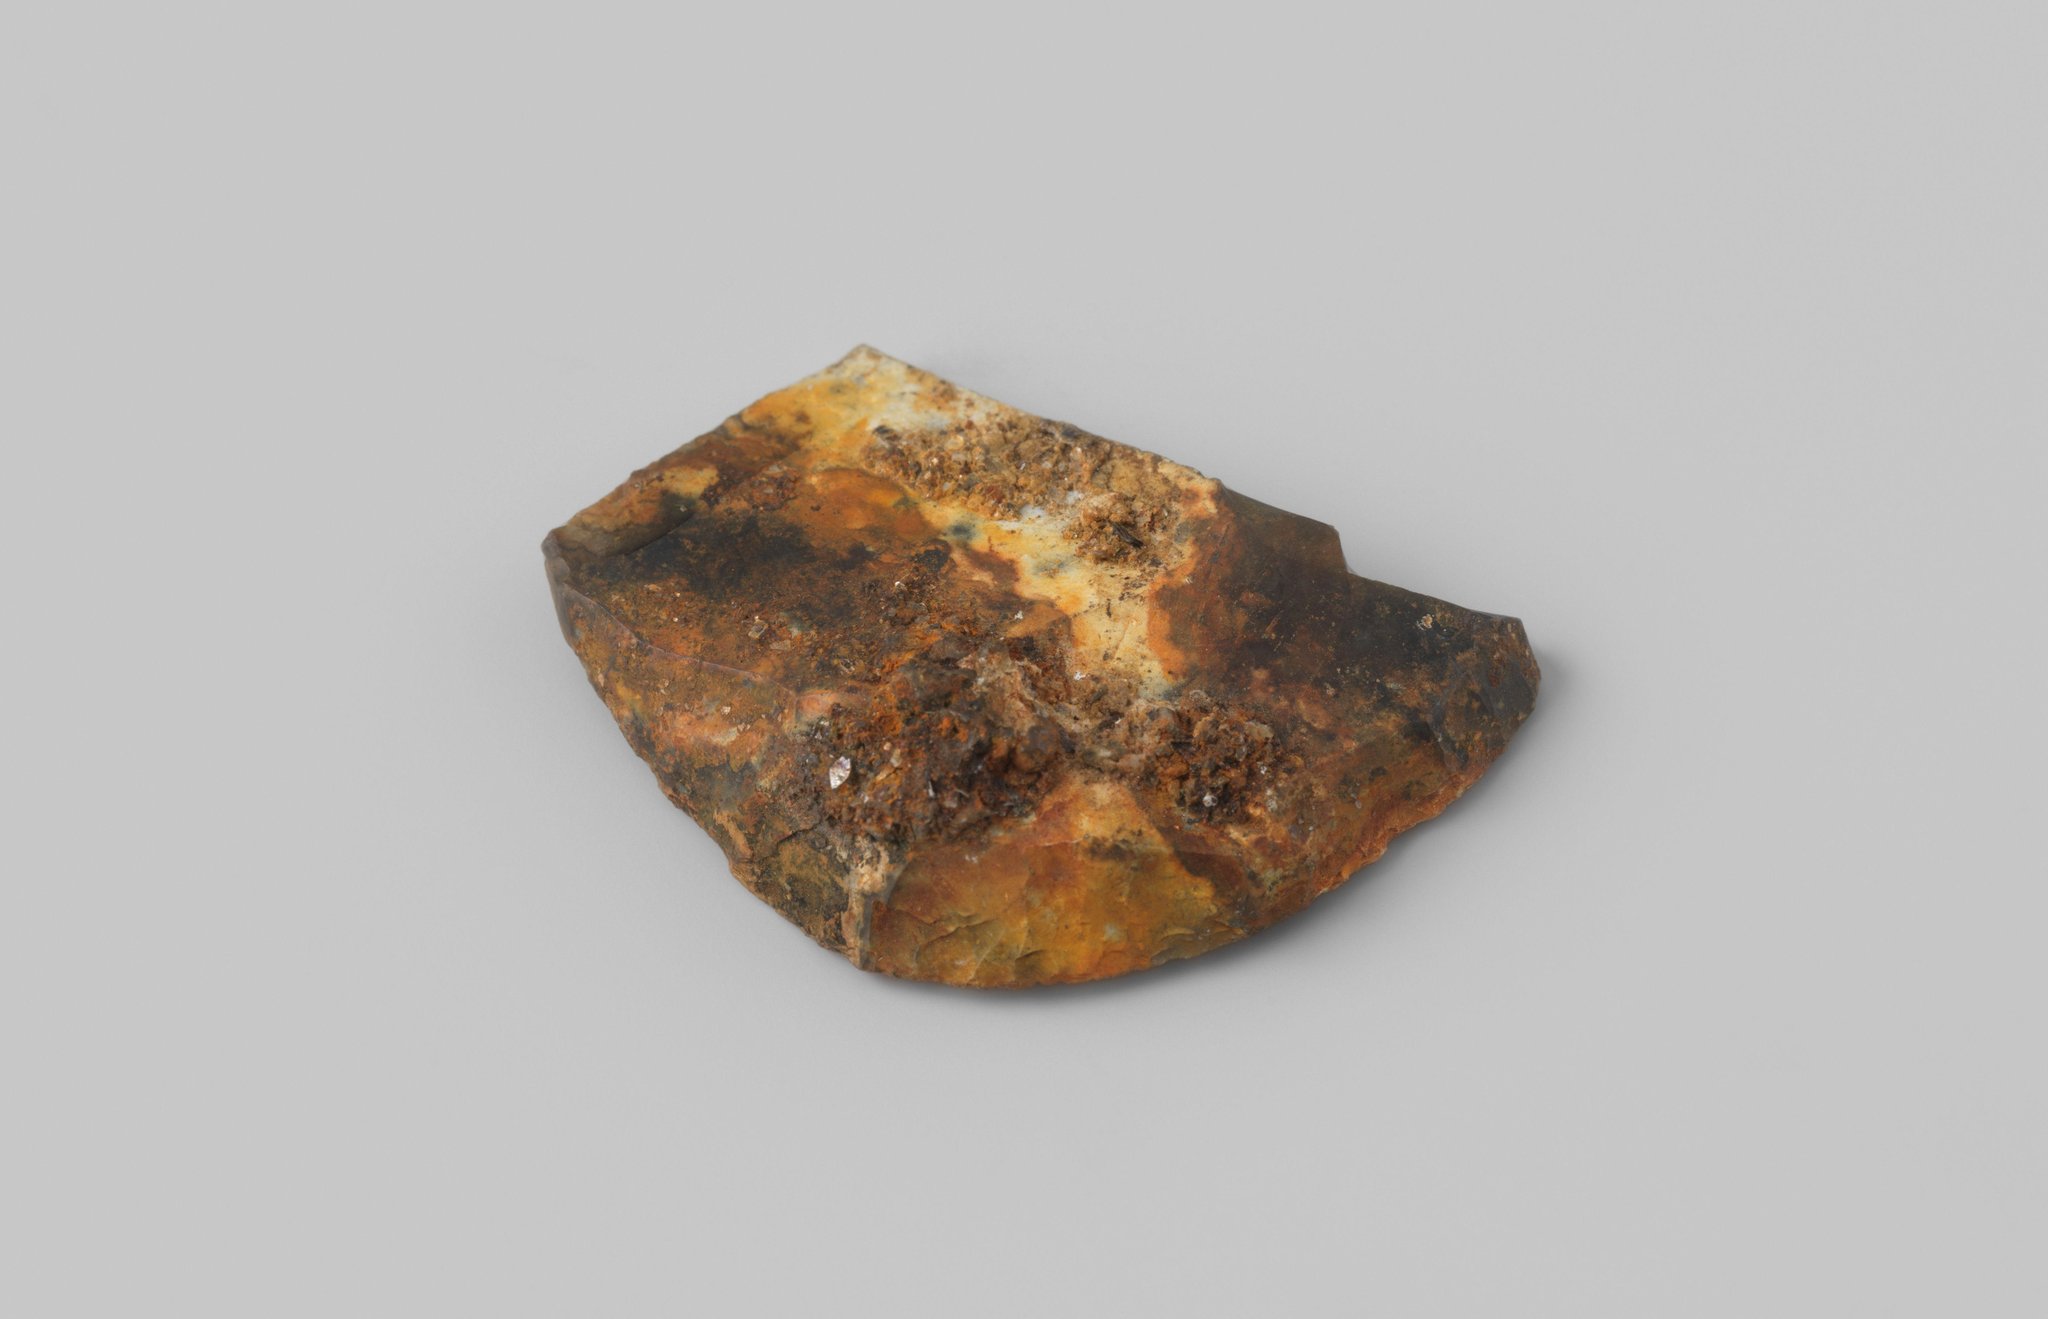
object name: gunflint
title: Vuursteen van een handwapen uit het wrak van de Oost-Indiëvaarder Hollandia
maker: Anonymous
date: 1700-1743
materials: stone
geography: netherlands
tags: verenigde oostindische compagnie, hollandia (schip), annet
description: Hand weapon, flint; fragm, sim. NG 1980-27H3128.